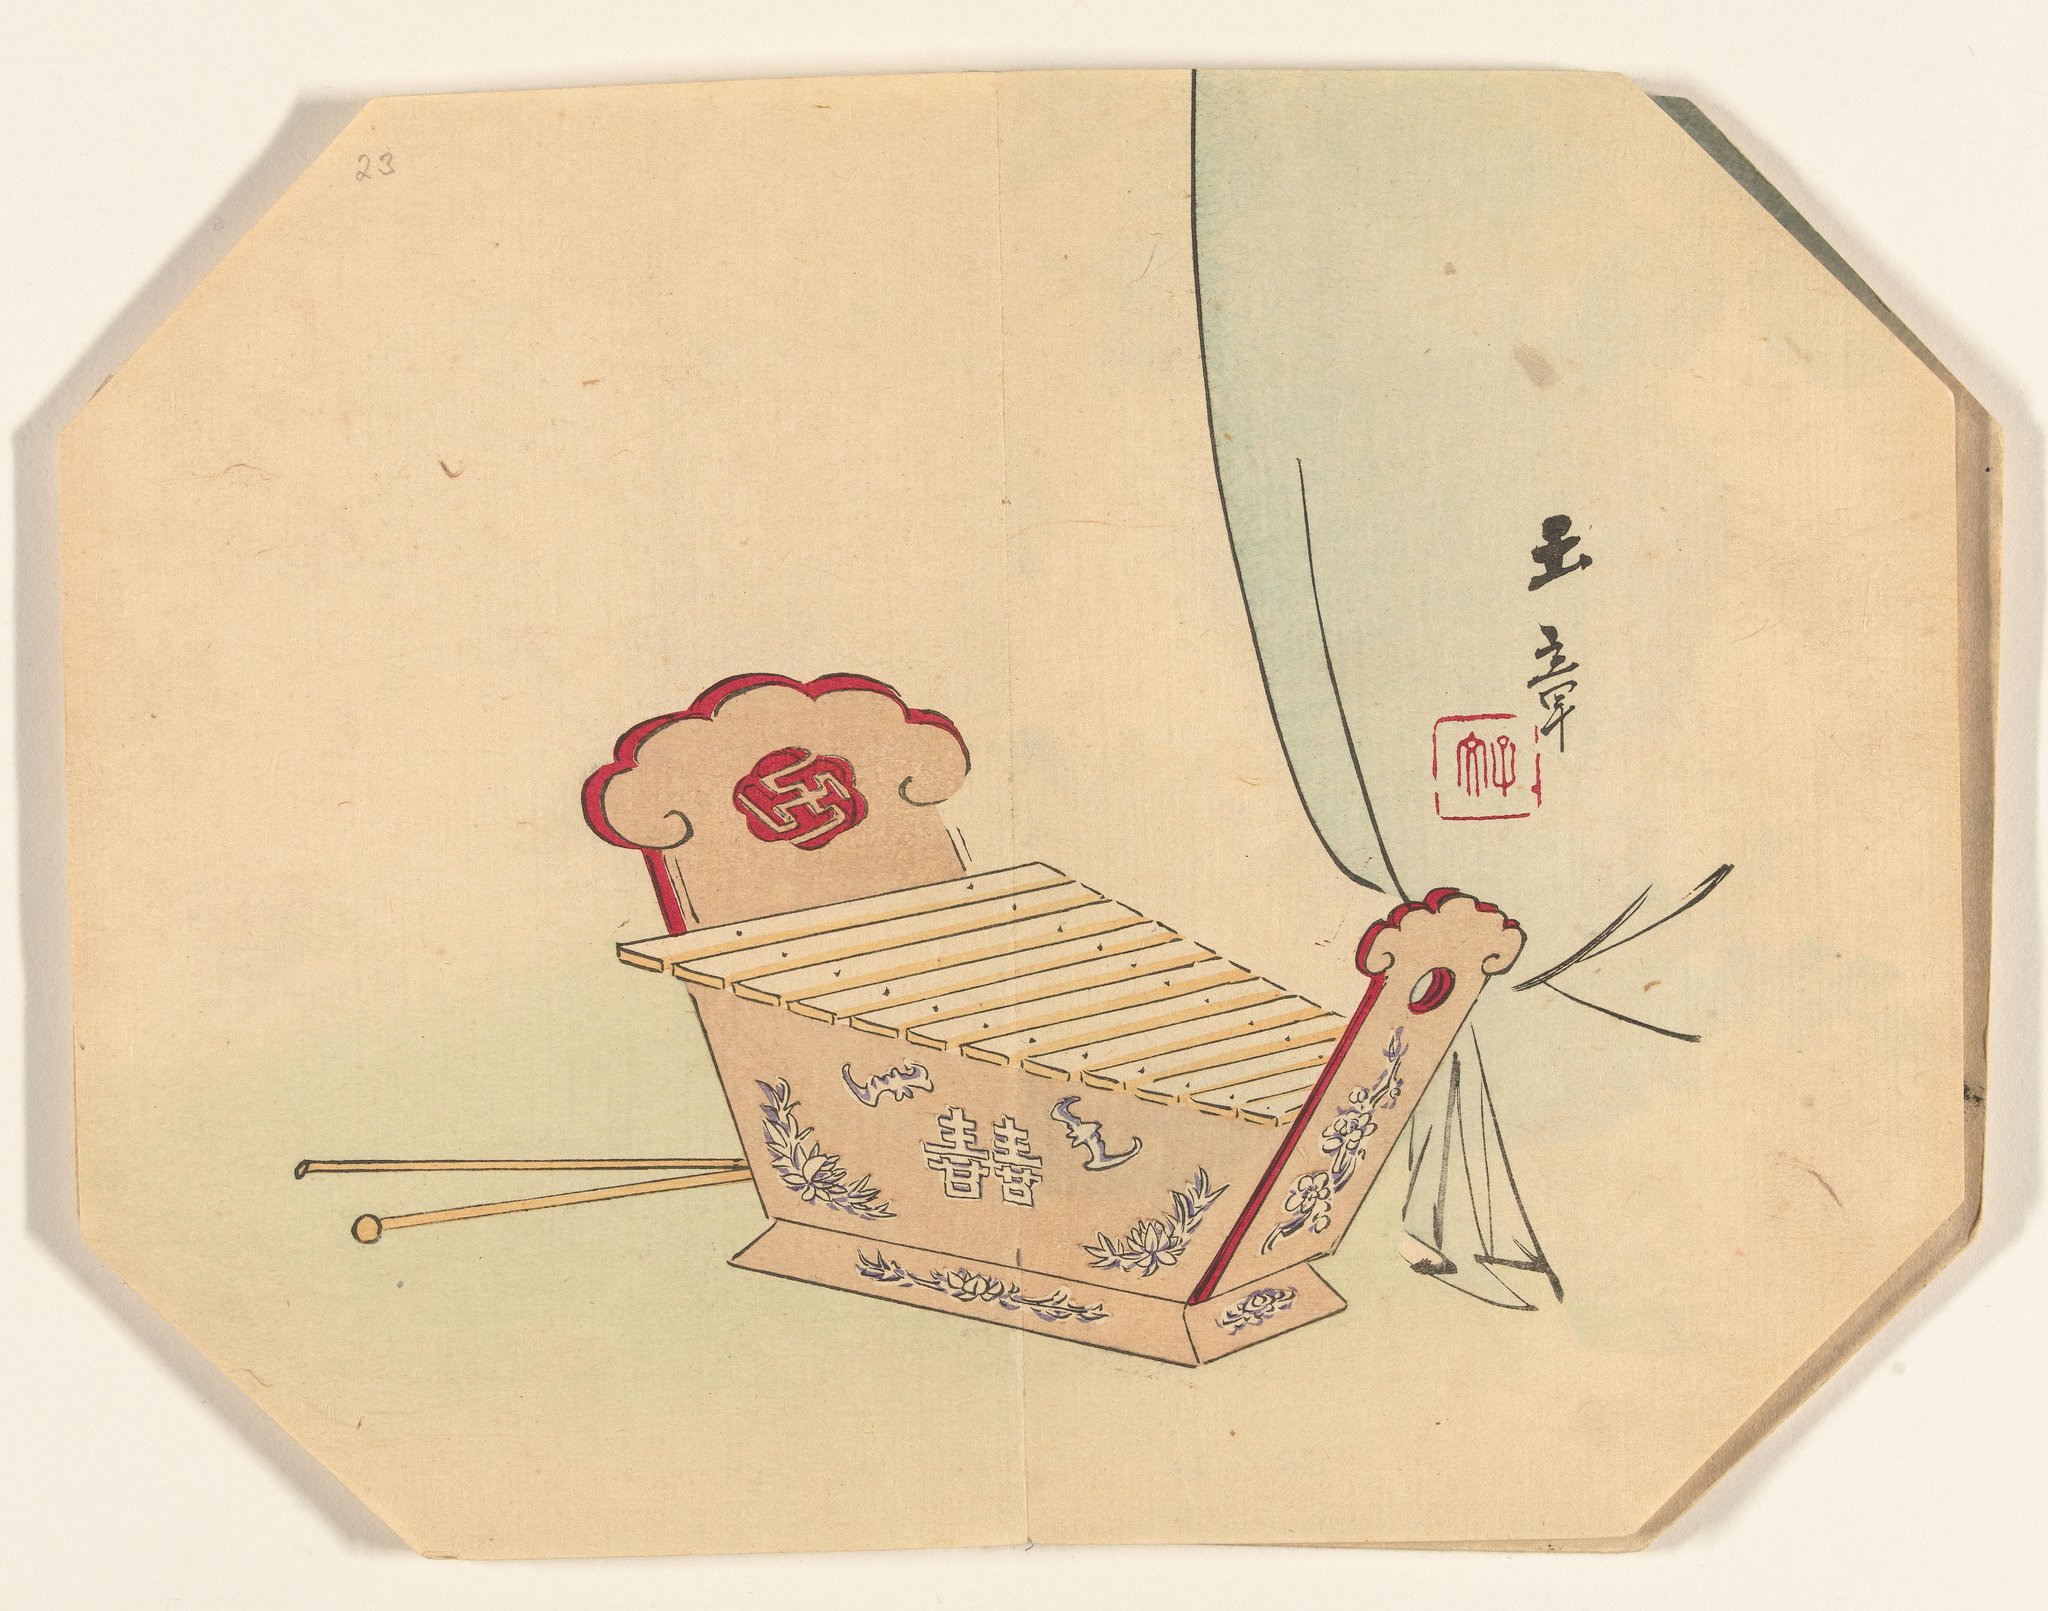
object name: album leaf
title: Xylofoon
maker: kawabata gyokusho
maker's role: print maker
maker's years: 1842-1913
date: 1880-1890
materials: paper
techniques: woodcut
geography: japan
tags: percussion instruments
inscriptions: collector's mark: Lugt 2228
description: Octogonale prent uit album met 39 prenten.